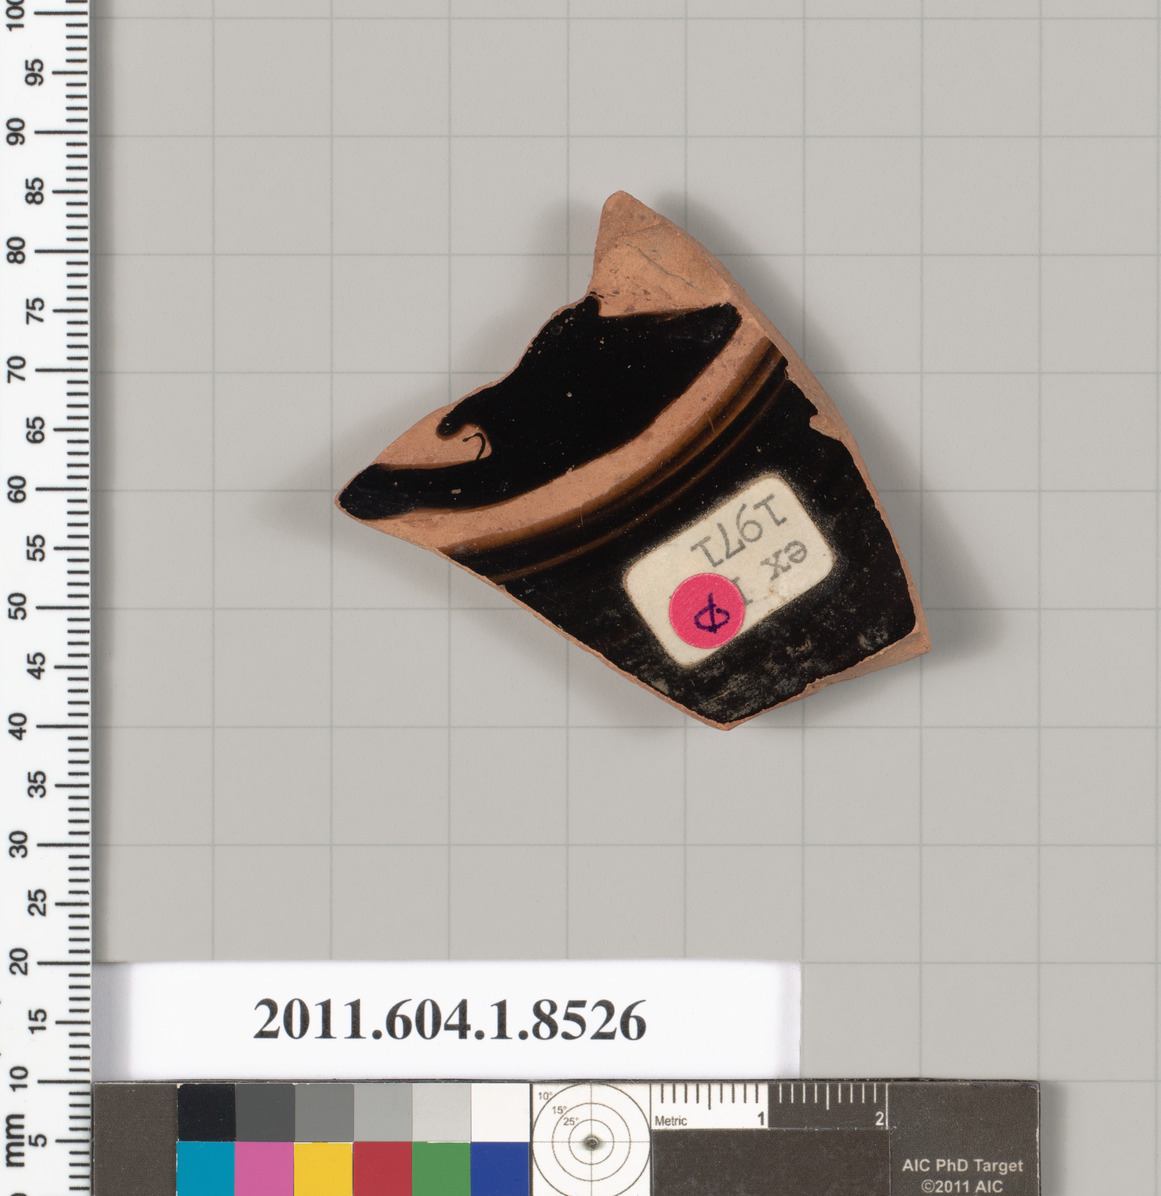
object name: kylix fragment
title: Terracotta fragment of a stemless kylix (drinking cup)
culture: greek, attic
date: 467-435 BCE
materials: terracotta